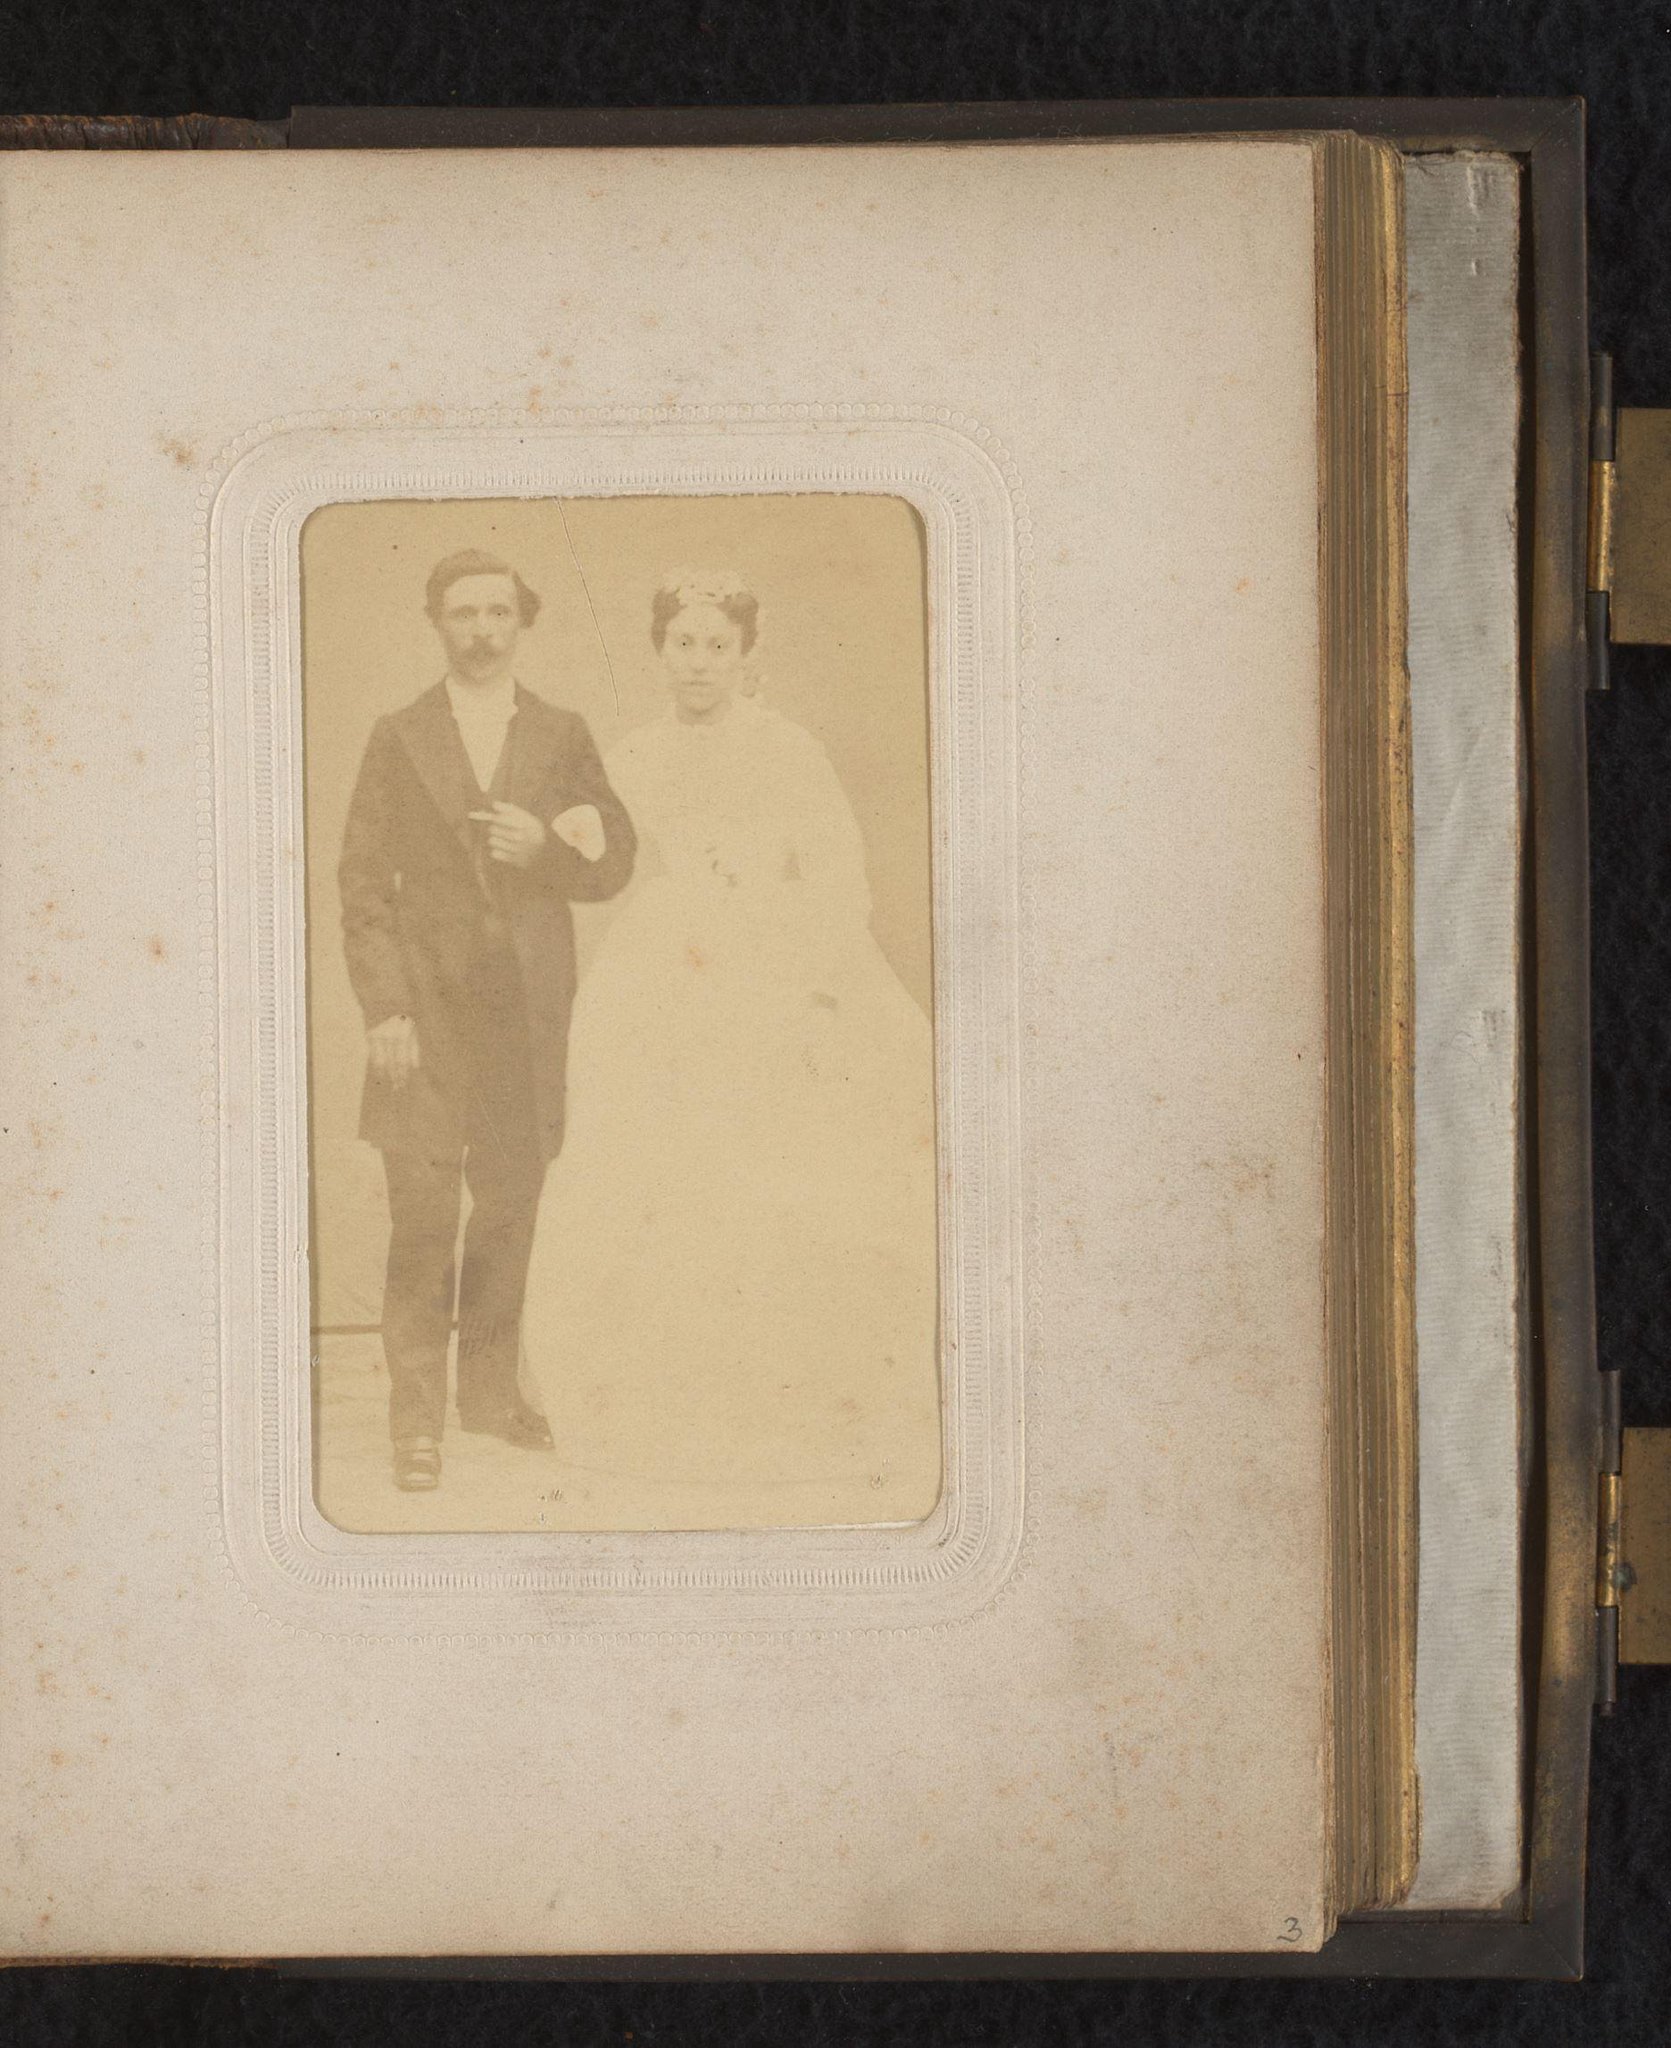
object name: photograph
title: Portret van een echtpaar in trouwkostuum, aangeduid als Angeline en Haury Mignot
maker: Anonymous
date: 1867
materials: cardboard, photographic support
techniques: albumen print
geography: france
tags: historical persons - bb - woman, historical persons, marriage, married couple, 'matrimonium'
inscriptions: annotation: ‘Angeline/ Mignot/ Femme/ H[au]ry/ Marie le 27/ Juillet 1867/ décédée le 21 Mai 1868/ dans sa 22e année’